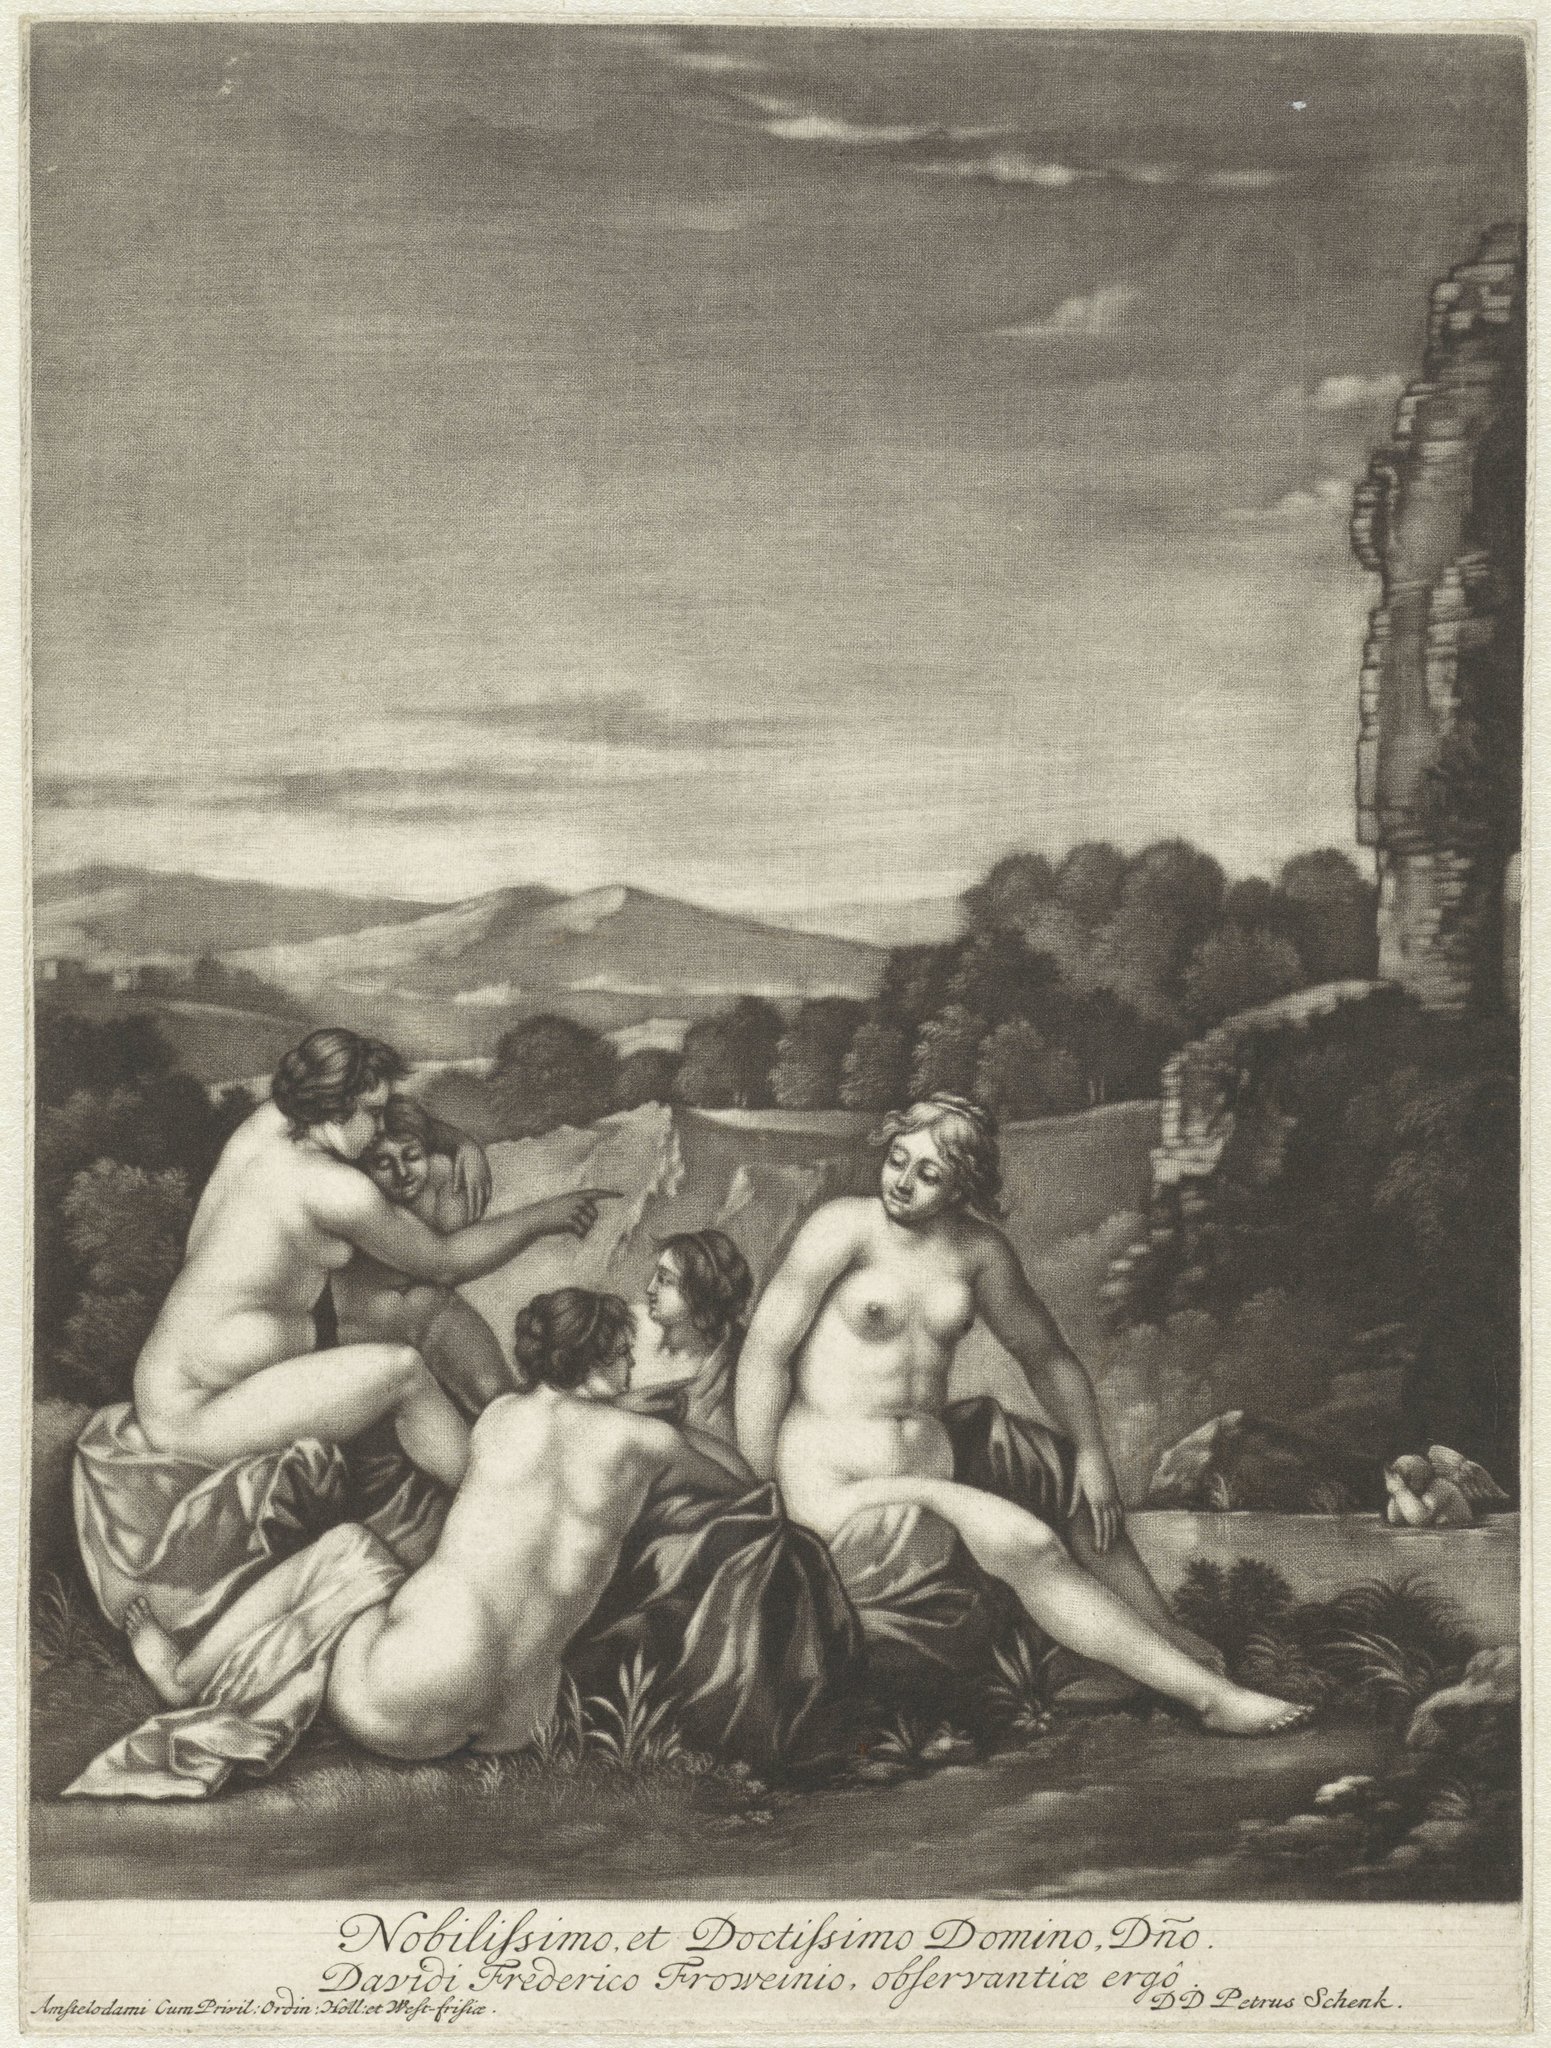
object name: print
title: Vijf nimfen in een landschap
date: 1680-1713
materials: paper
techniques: engraving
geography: amsterdam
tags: landscapes, other types of nymph(s), cupids: 'amores', 'amoretti', 'putti'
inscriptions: collector's mark: Lugt 2228, collector's mark: Lugt 2760